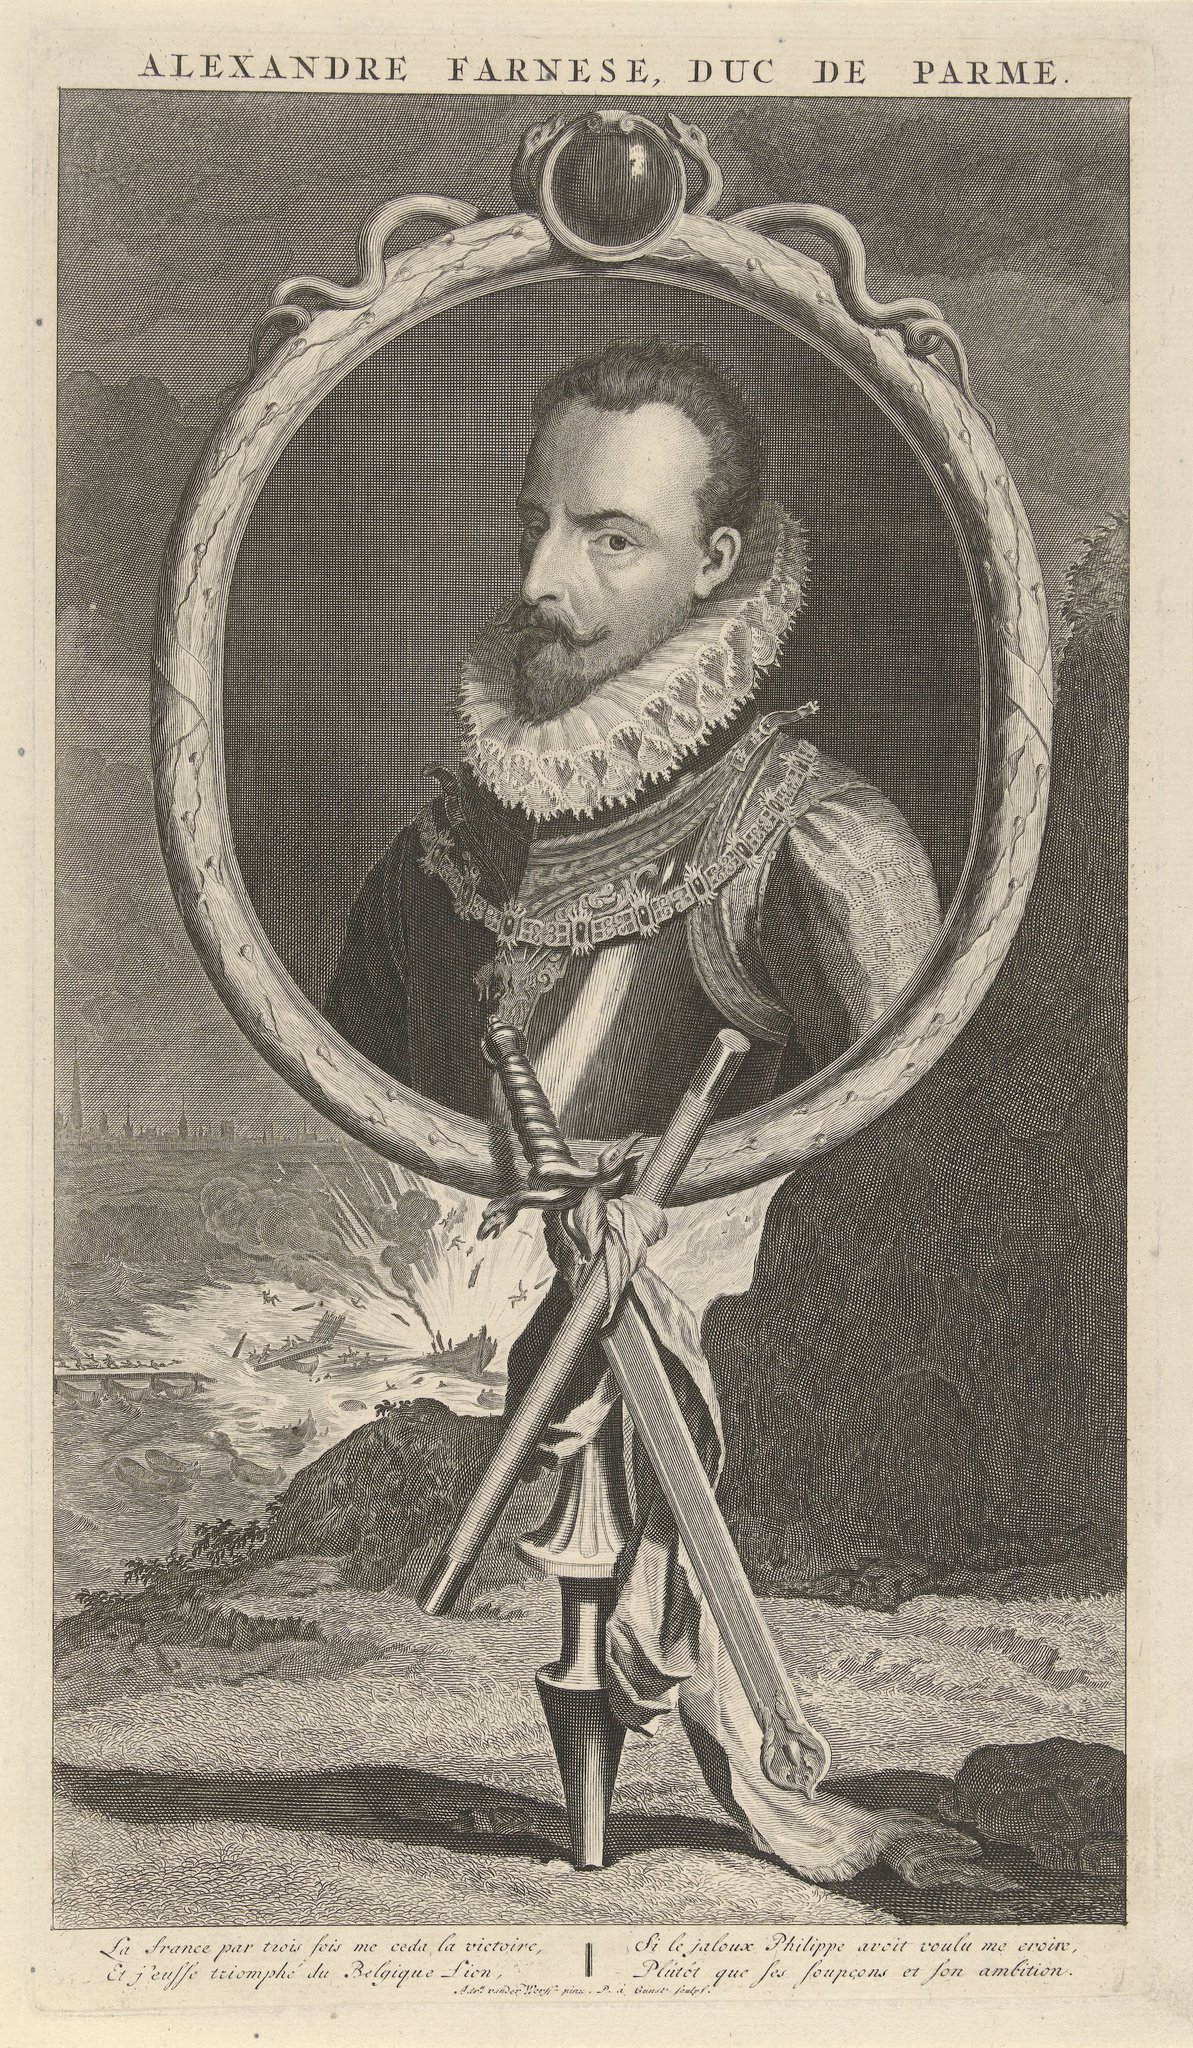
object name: print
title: Portret van Alessandro Farnese, hertog van Parma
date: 1669-1731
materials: paper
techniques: engraving, etching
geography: amsterdam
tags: rome, alessandro farnese (landvoogd van de nederlanden en hertog van parma en piacenza)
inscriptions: collector's mark: Lugt 2228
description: Alessandro Farnese, hertog van Parma en landvoogd van de Nederlanden. Op de achtergrond het opblazen met branders van de schipbrug aangelegd door de hertog van Parma in de Schelde vóór Antwerpen, 5 april 1585.